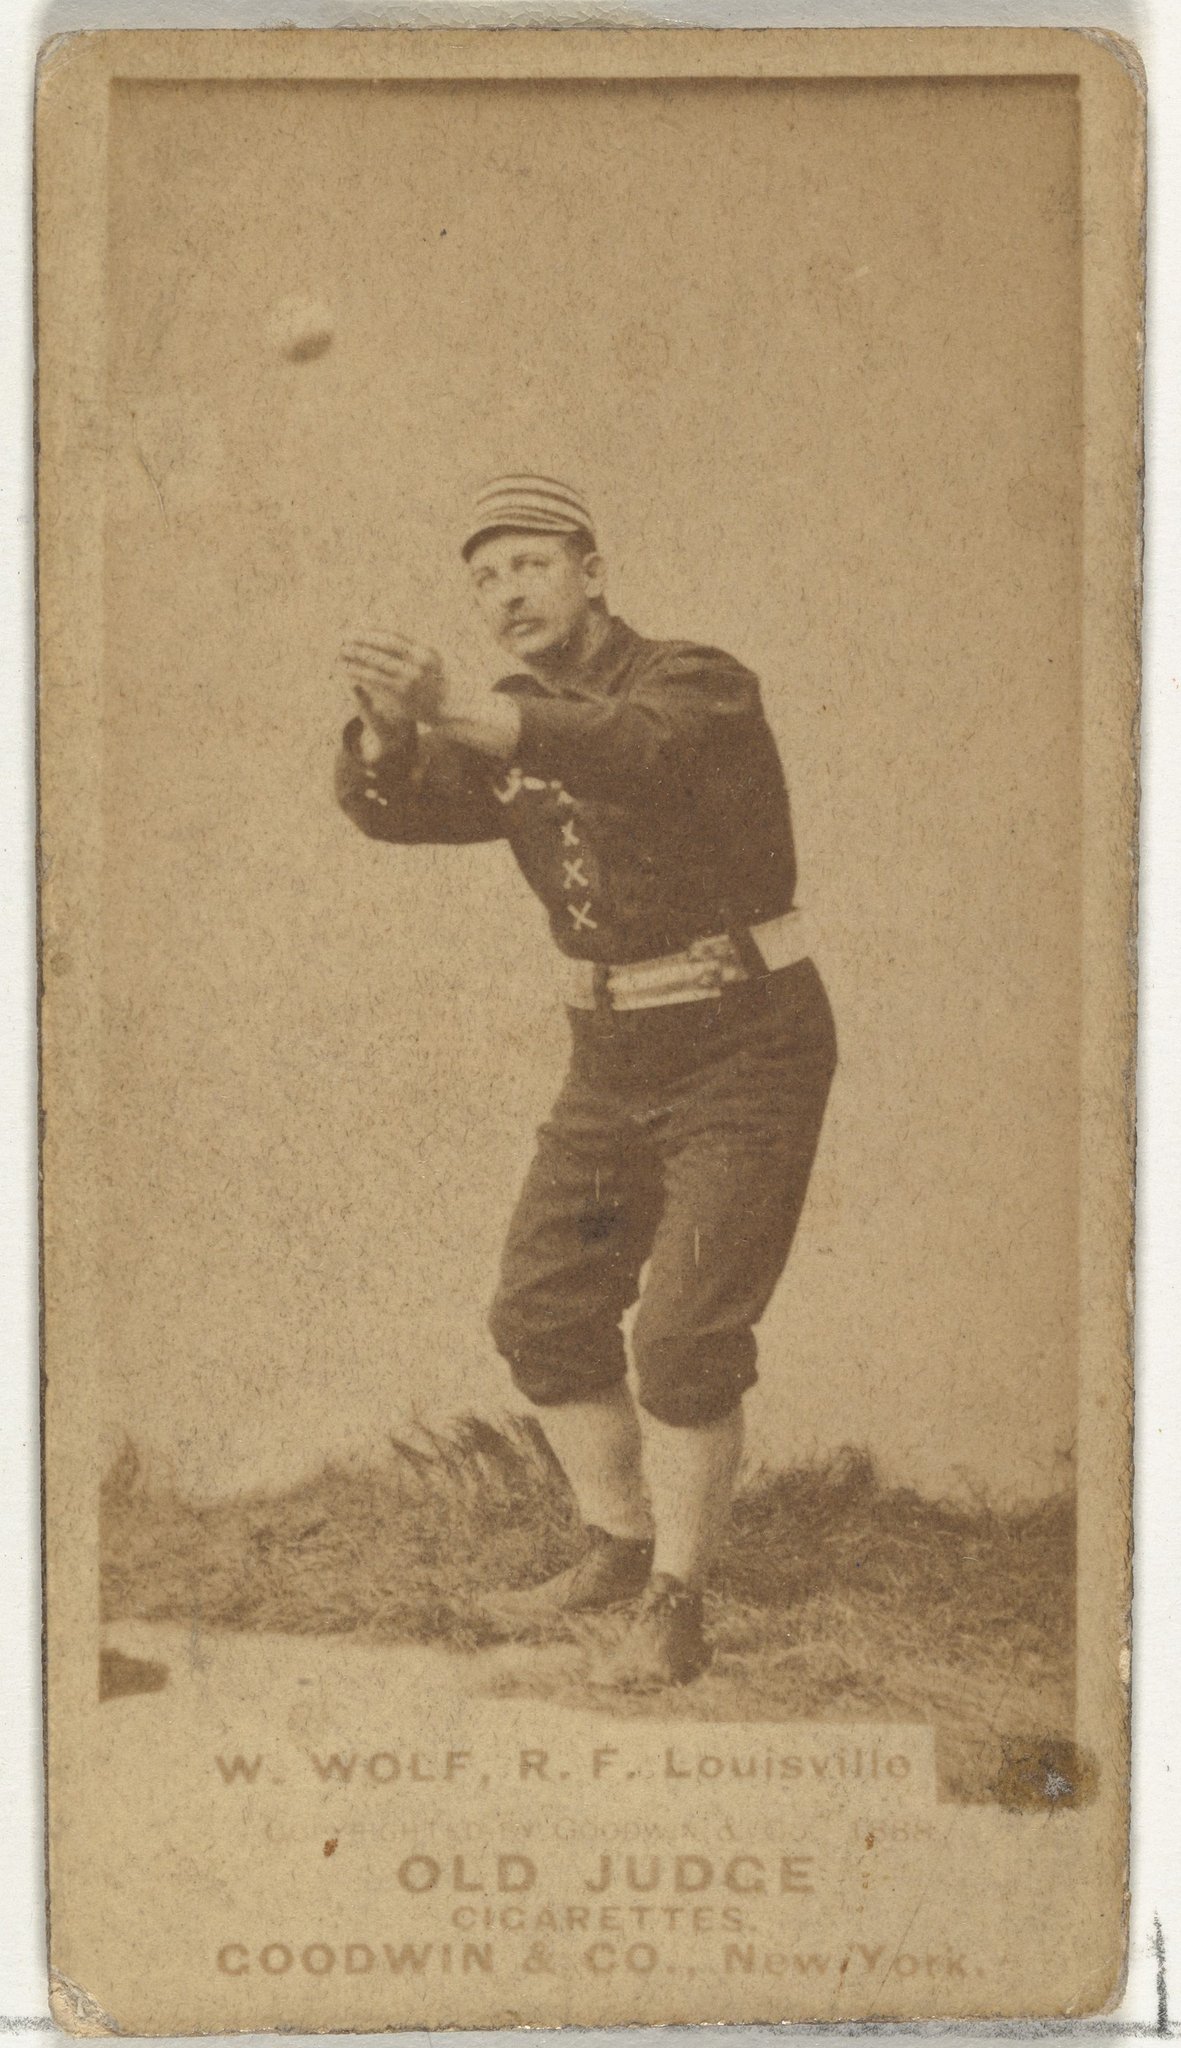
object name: baseball card, photograph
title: William Van Winkle "Jimmy" Wolf, Right Field, Louisville Colonels, from the Old Judge series (N172) for Old Judge Cigarettes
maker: goodwin & company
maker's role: publisher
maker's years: 1850-1950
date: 1888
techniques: albumen silver print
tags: men,portraits,baseball,athletes